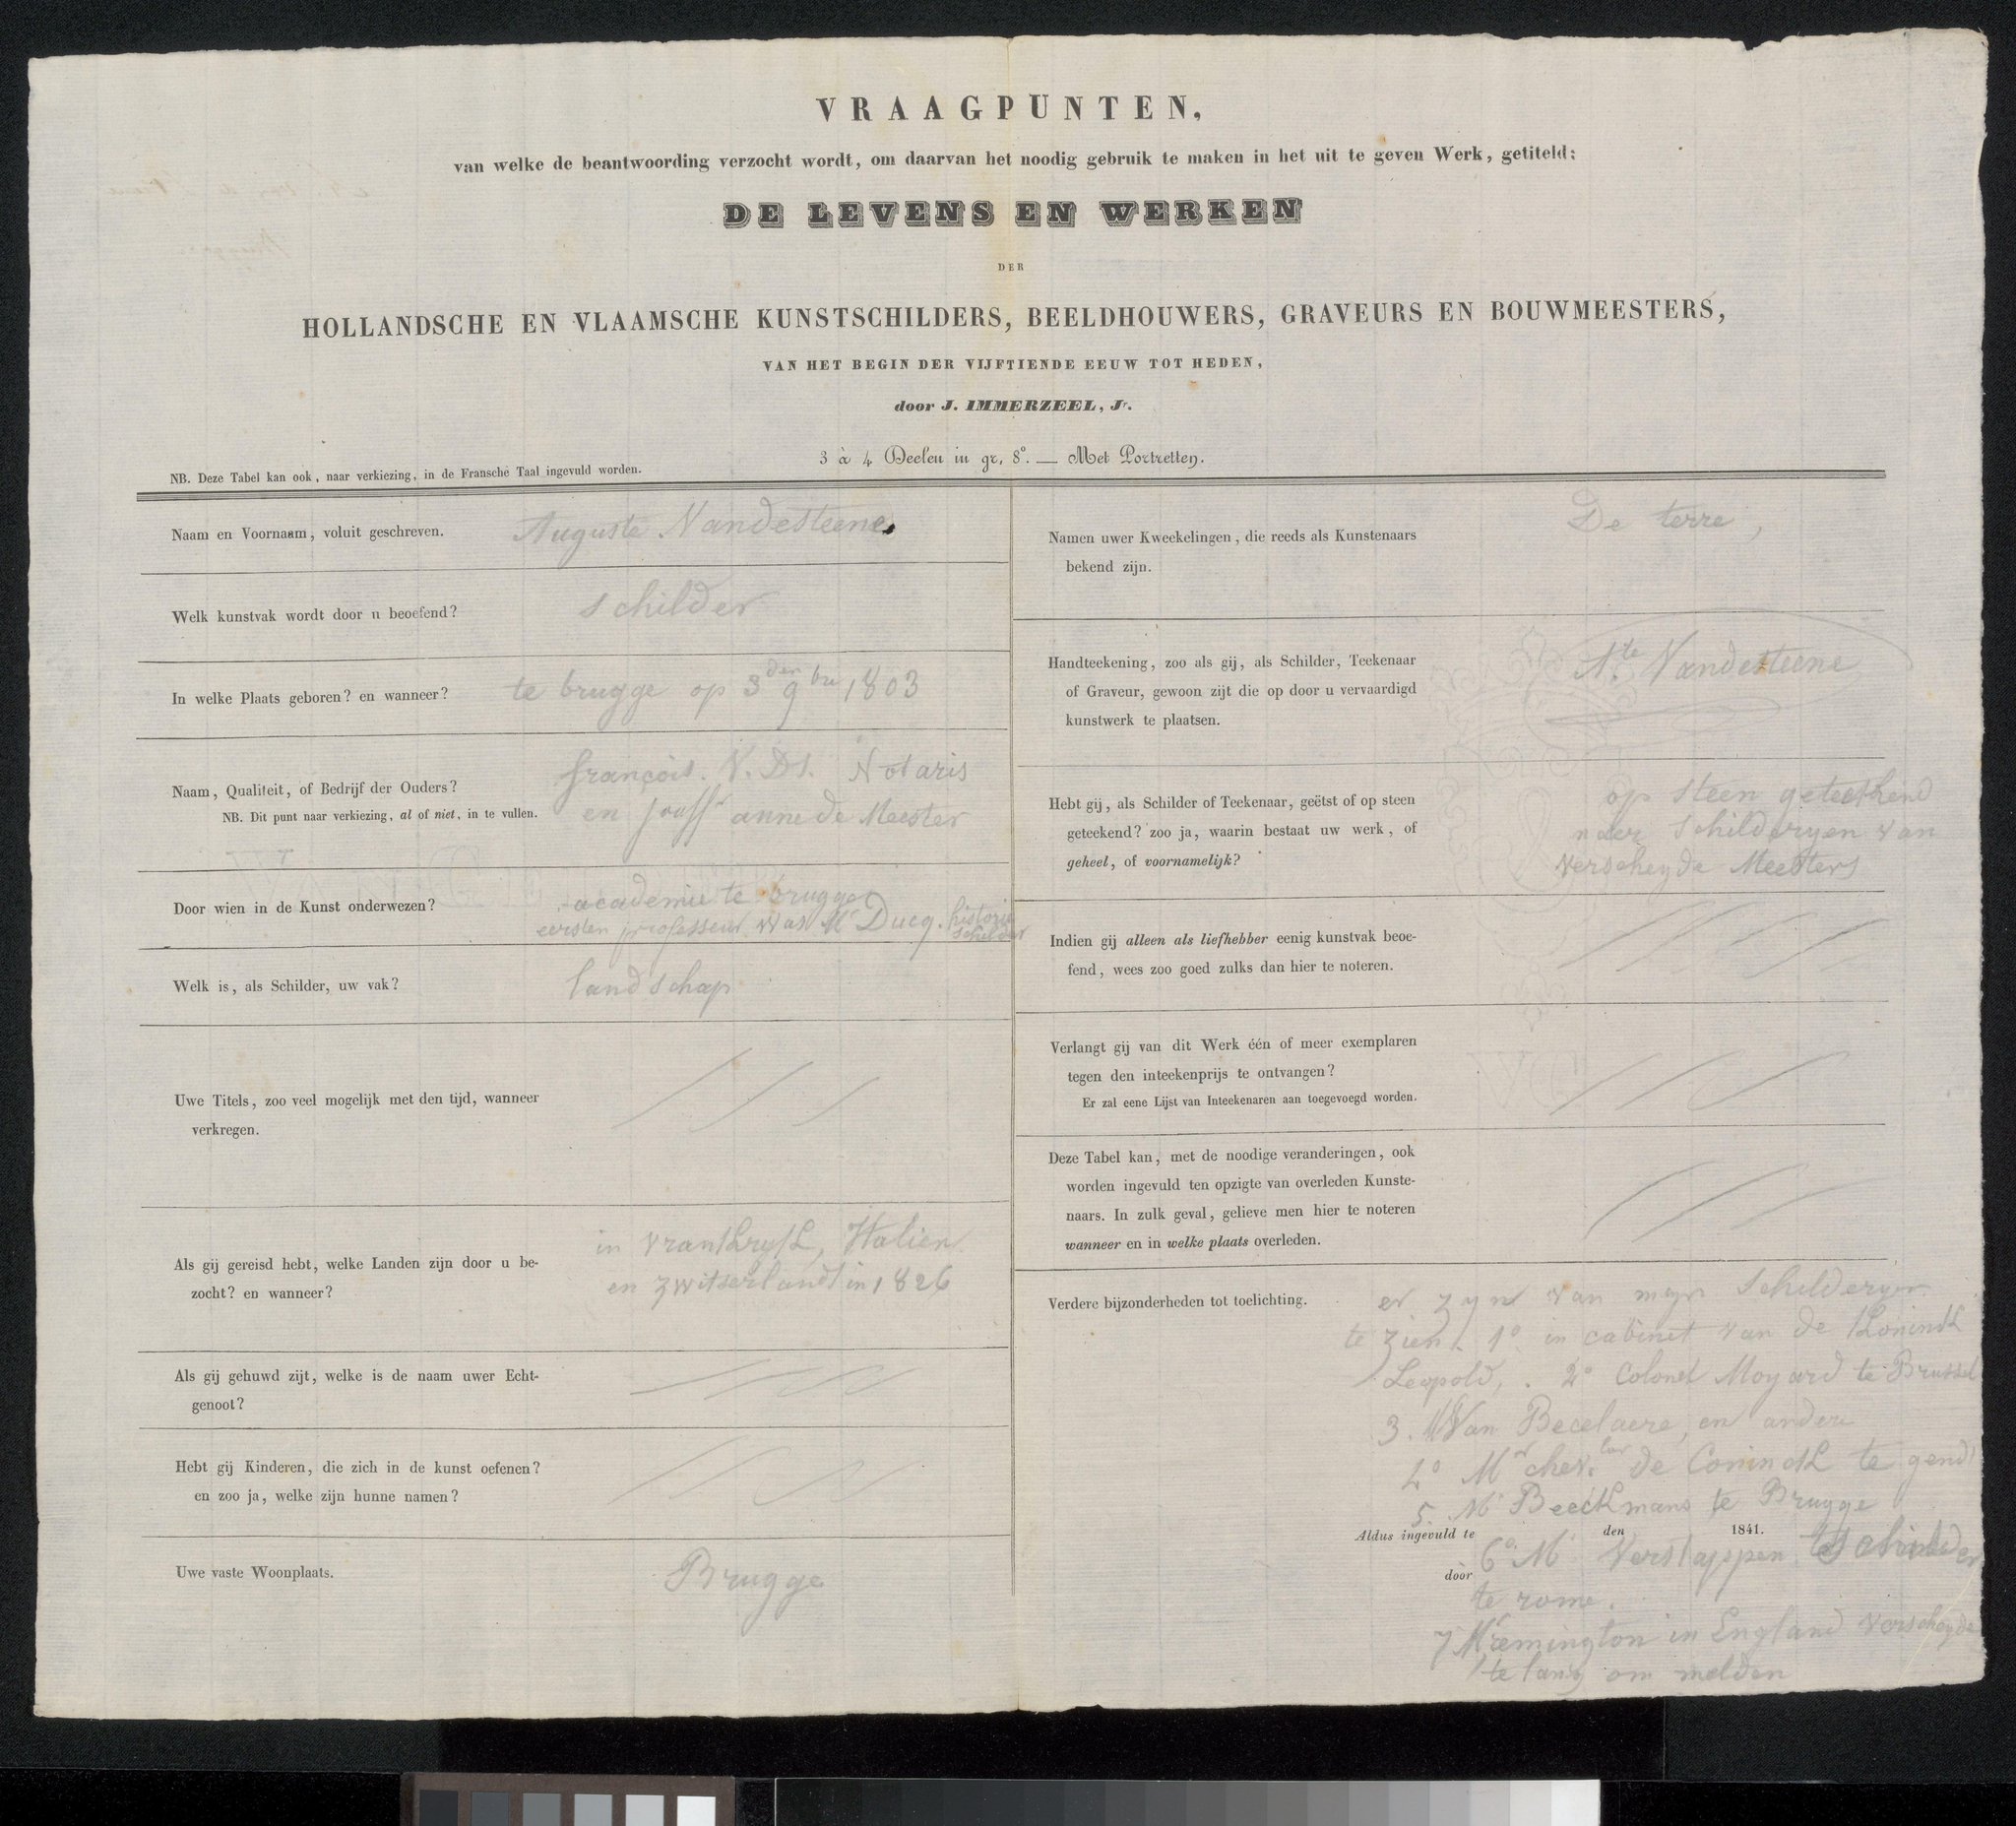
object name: manuscript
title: Enquêteformulier ingevuld door Augustus van der Steene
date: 1840-1841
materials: paper, pencil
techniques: printing, writing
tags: bruges, draughtsman, augustus van der steene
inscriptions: inscription: ‘Vraagpunten,/ van welke de beantwoording verzocht wordt, om daarvan het noodig gebruik te maken in het uit te geven Werk, getiteld: De levens en werken/ der Hollandsche en Vlaamsche kunstschilders, beeldhouwers,/ graveurs en bouwmeesters, van het begin der vijftiende eeuw tot heden/ door J. Immerzeel, Jr.’, watermark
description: Opgenomen in: Immerzeel, J. Jr., De levens en werken der Hollandsche en Vlaamsche kunstschilders, beeldhouwers, graveurs en bouwmeesters, van het begin der vijftiende eeuw tot heden, Amsterdam: J.C. van Kesteren, 1842-1843.